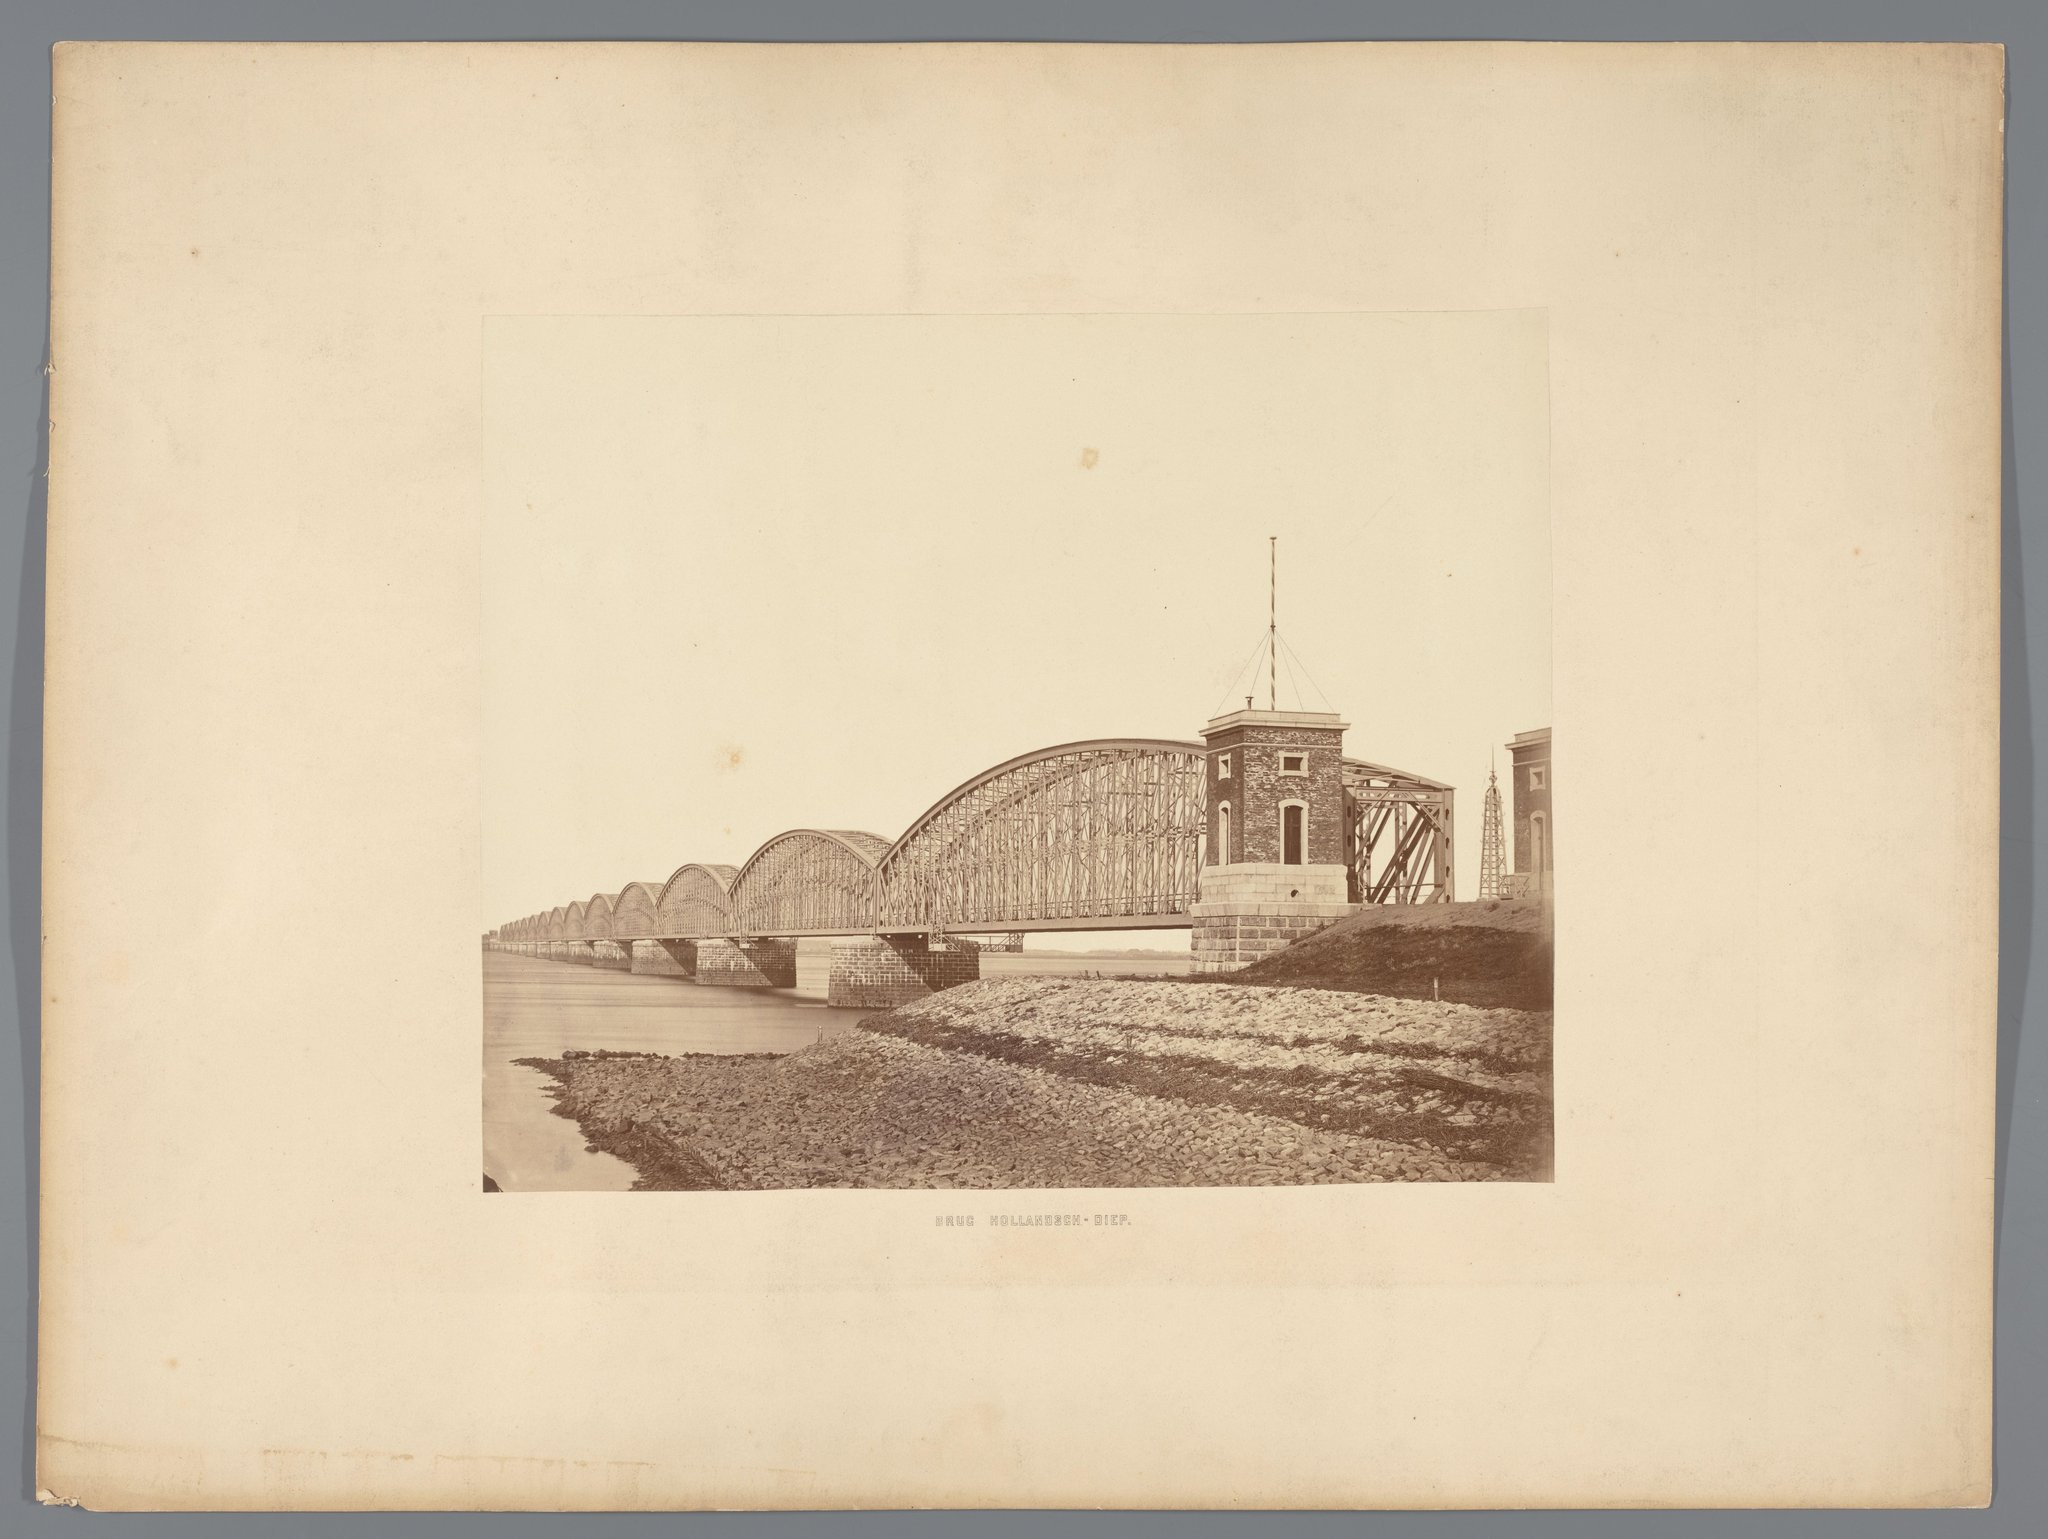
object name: photograph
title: Brug Hollandsch-Diep [Spoorbrug over het Hollands Diep bij Moerdijk]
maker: pieter oosterhuis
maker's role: draughtsman, print maker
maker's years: 1816-1885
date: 1871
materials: cardboard, paper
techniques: photography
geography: netherlands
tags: moerdijk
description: Foto op karton van de spoorbrug over het Hollands Diep, zijaanzicht.